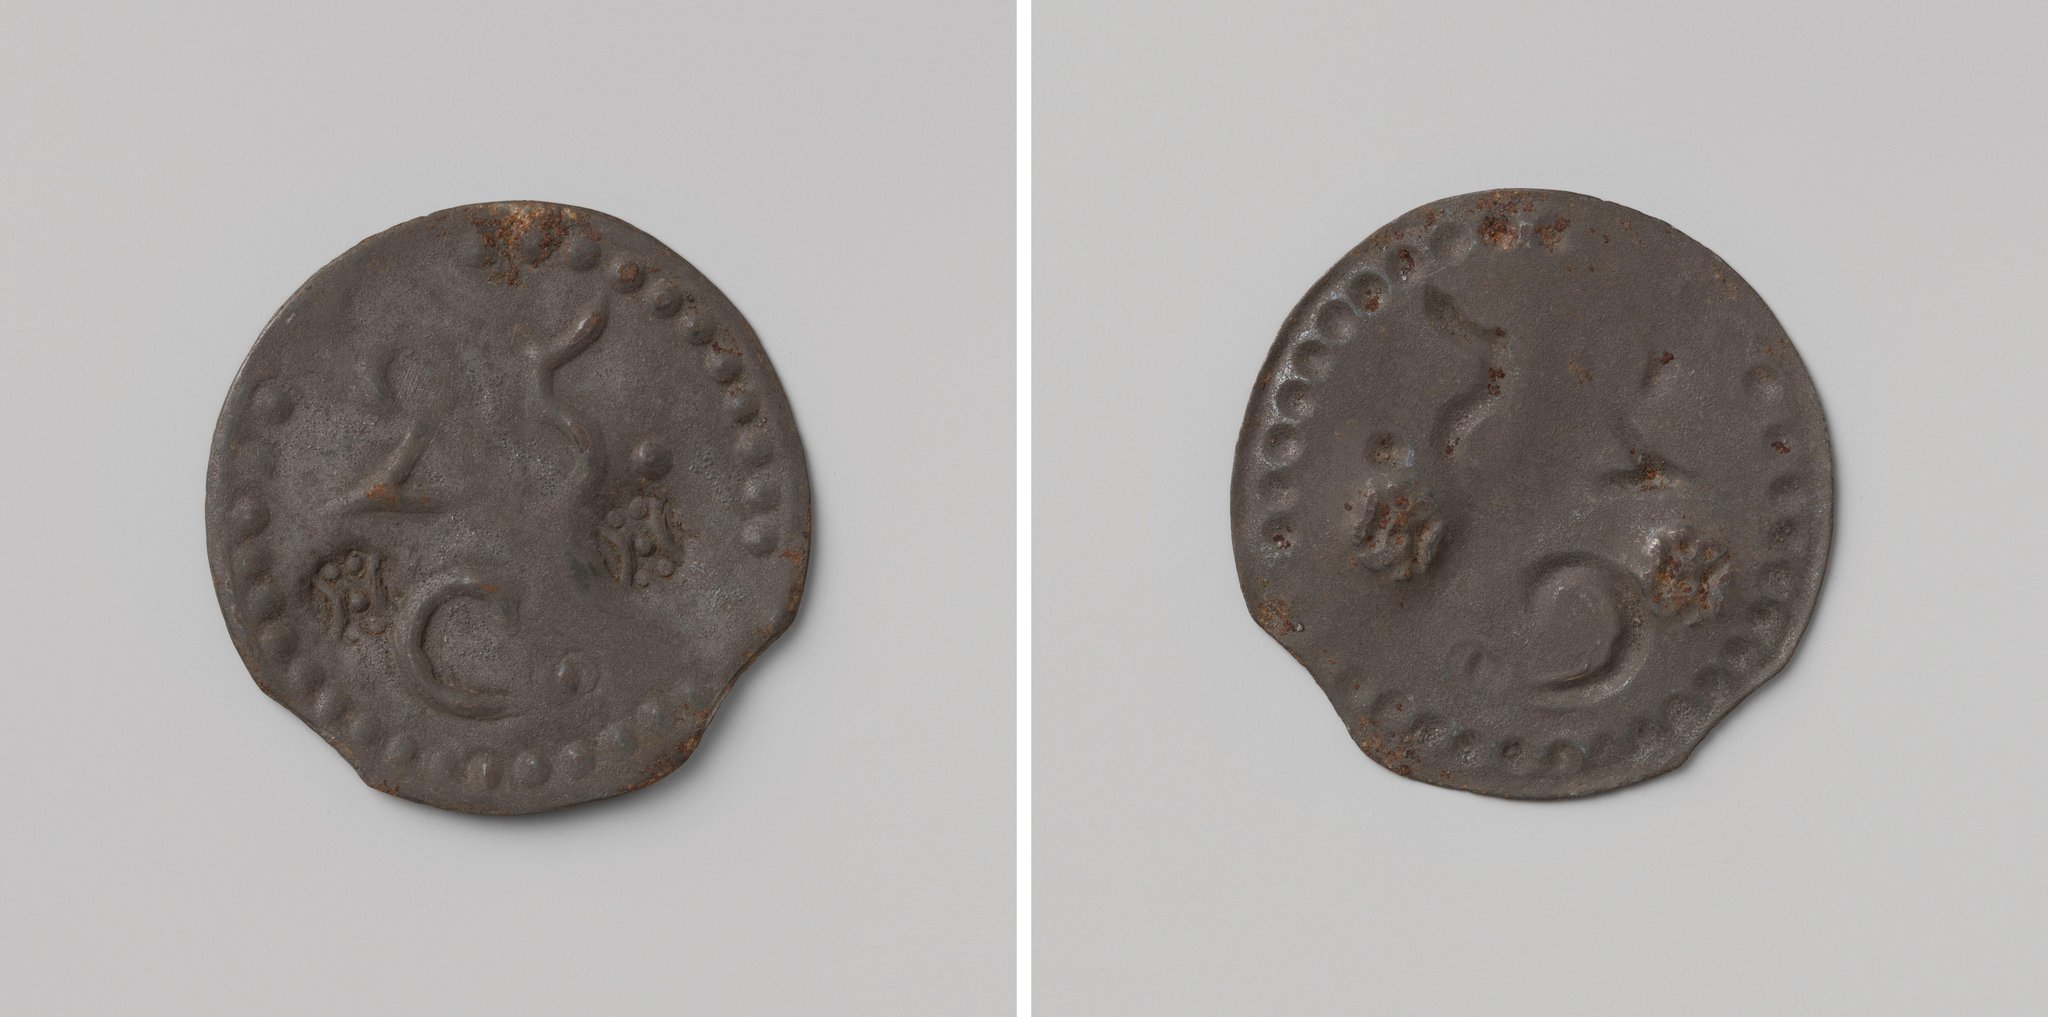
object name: huismunt prison money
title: Strafgevangenis Ommerschans, huismunt geslagen op last van de Maatschappij van Weldadigheid ter waarde van 25 cent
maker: Anonymous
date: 1822-1830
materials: metal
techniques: striking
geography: ommerschans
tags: maatschappij van weldadigheid, ommerschans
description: eenzijdige munt. Voorzijde: waardeaanduiding binnen parelrand; links en rechts: merk. Keerzijde: blanco